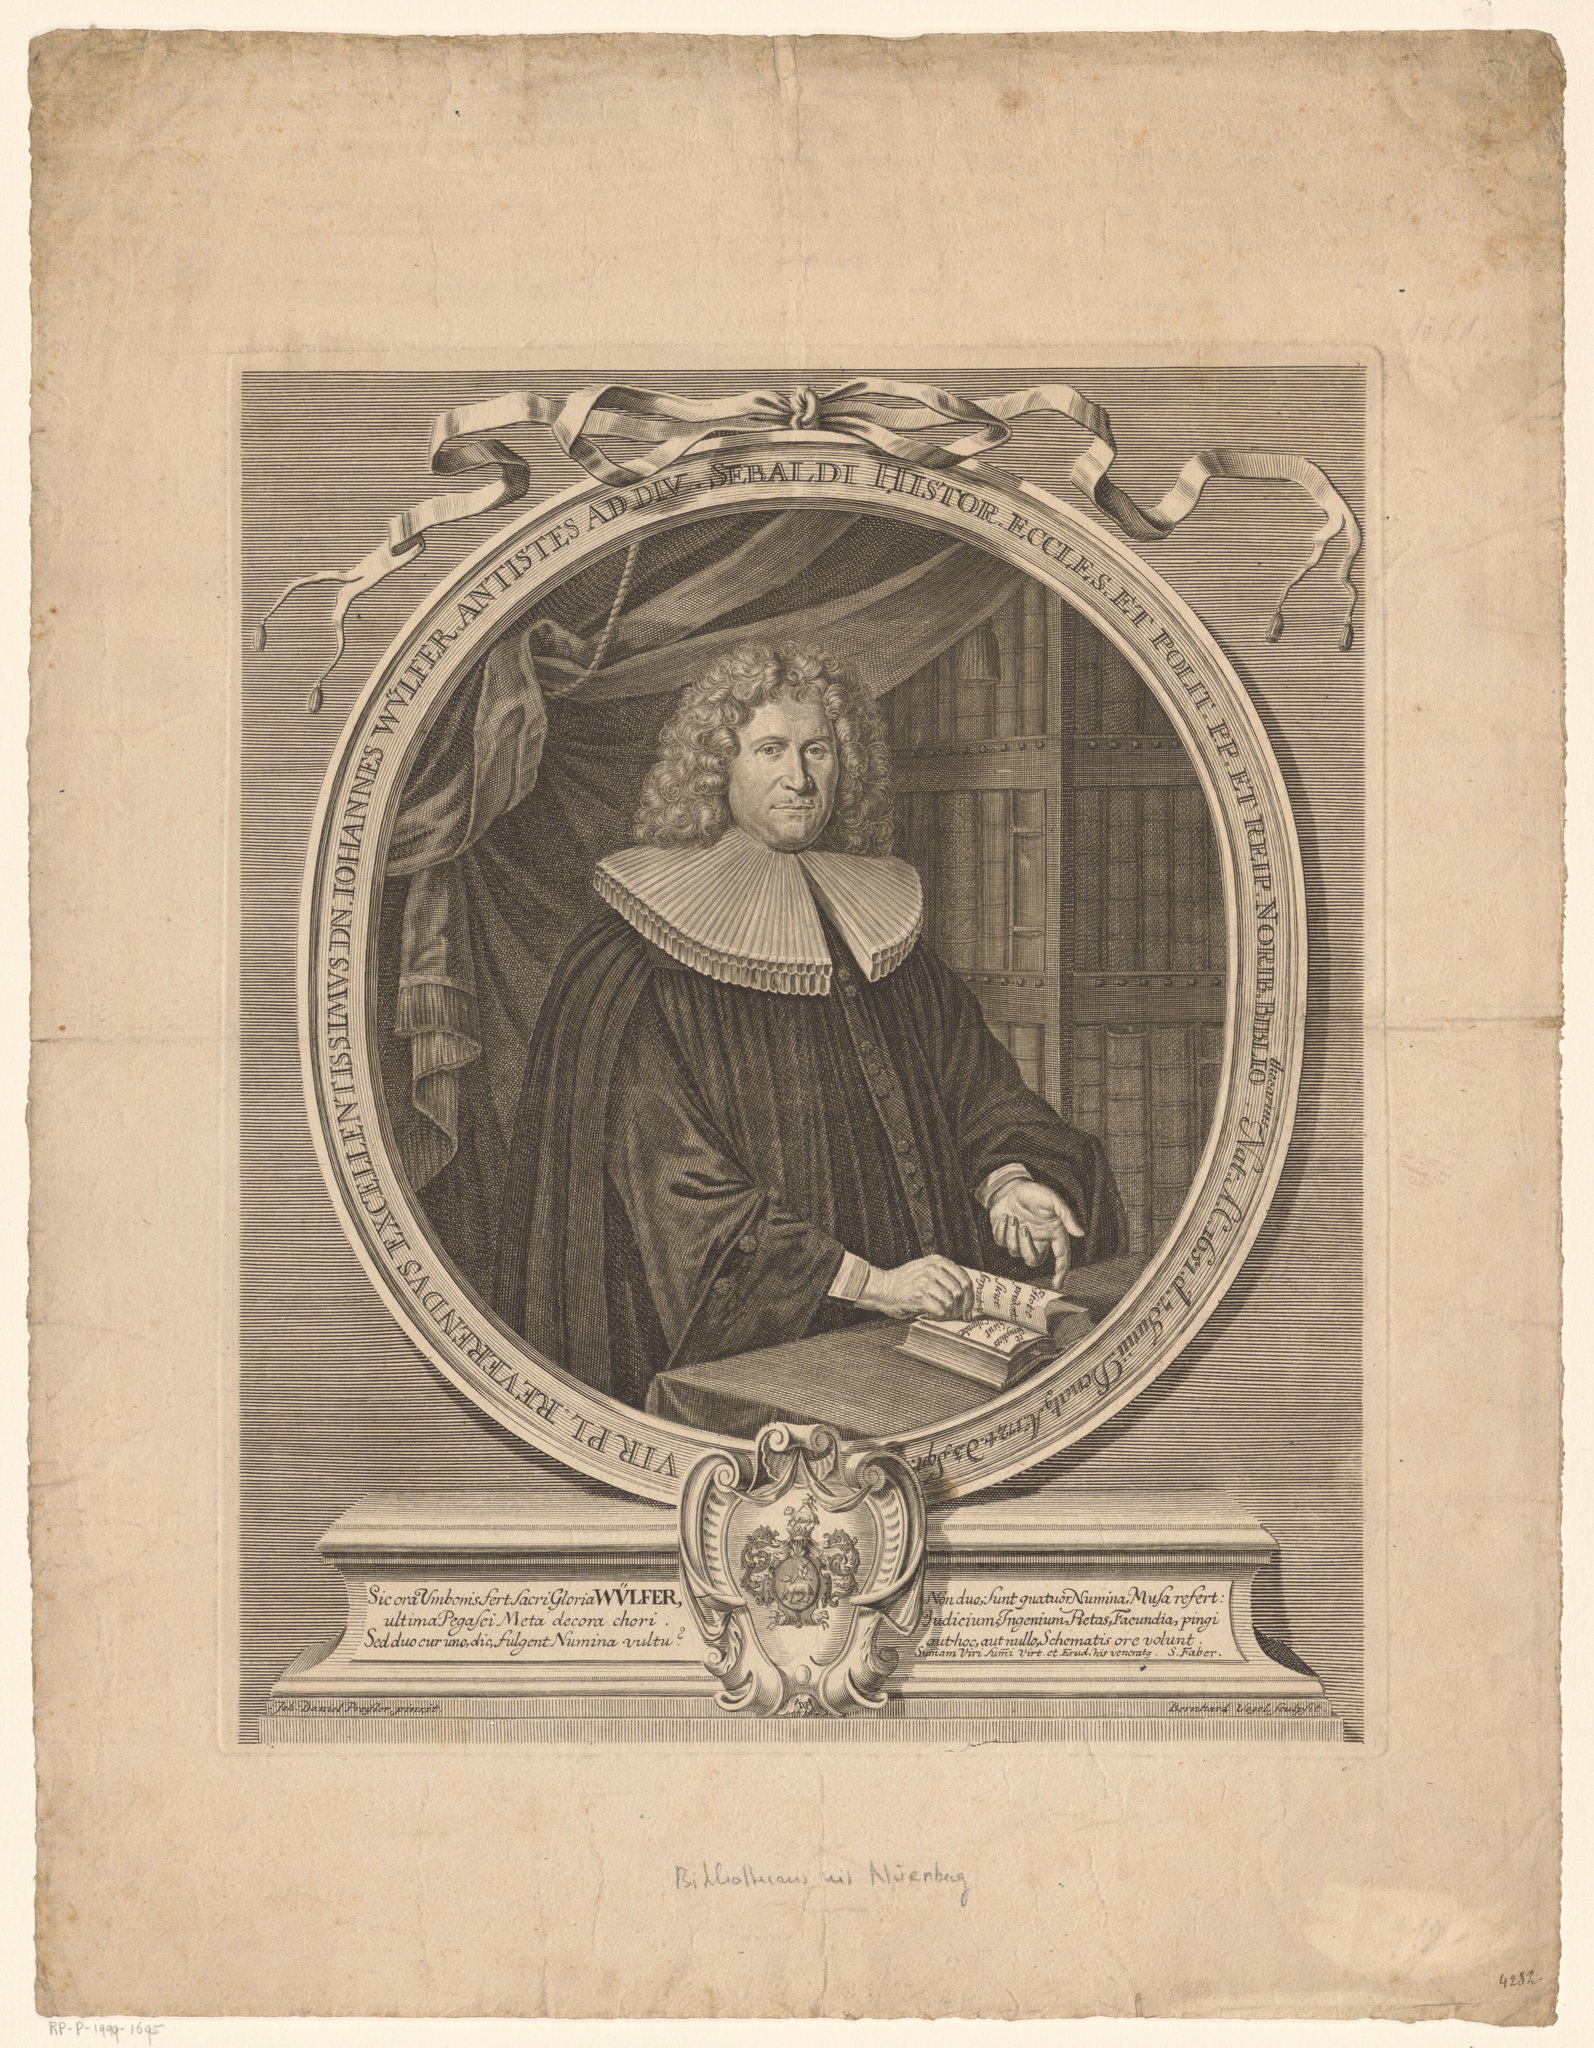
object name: print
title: Portret van Johannes Wülfer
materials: paper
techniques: engraving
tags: johannes wülfer, historical persons, armorial bearing, heraldry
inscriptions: collector's mark: Lugt 2228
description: Onder het portret twee kolommen met elk drie regels Latijnse tekst.